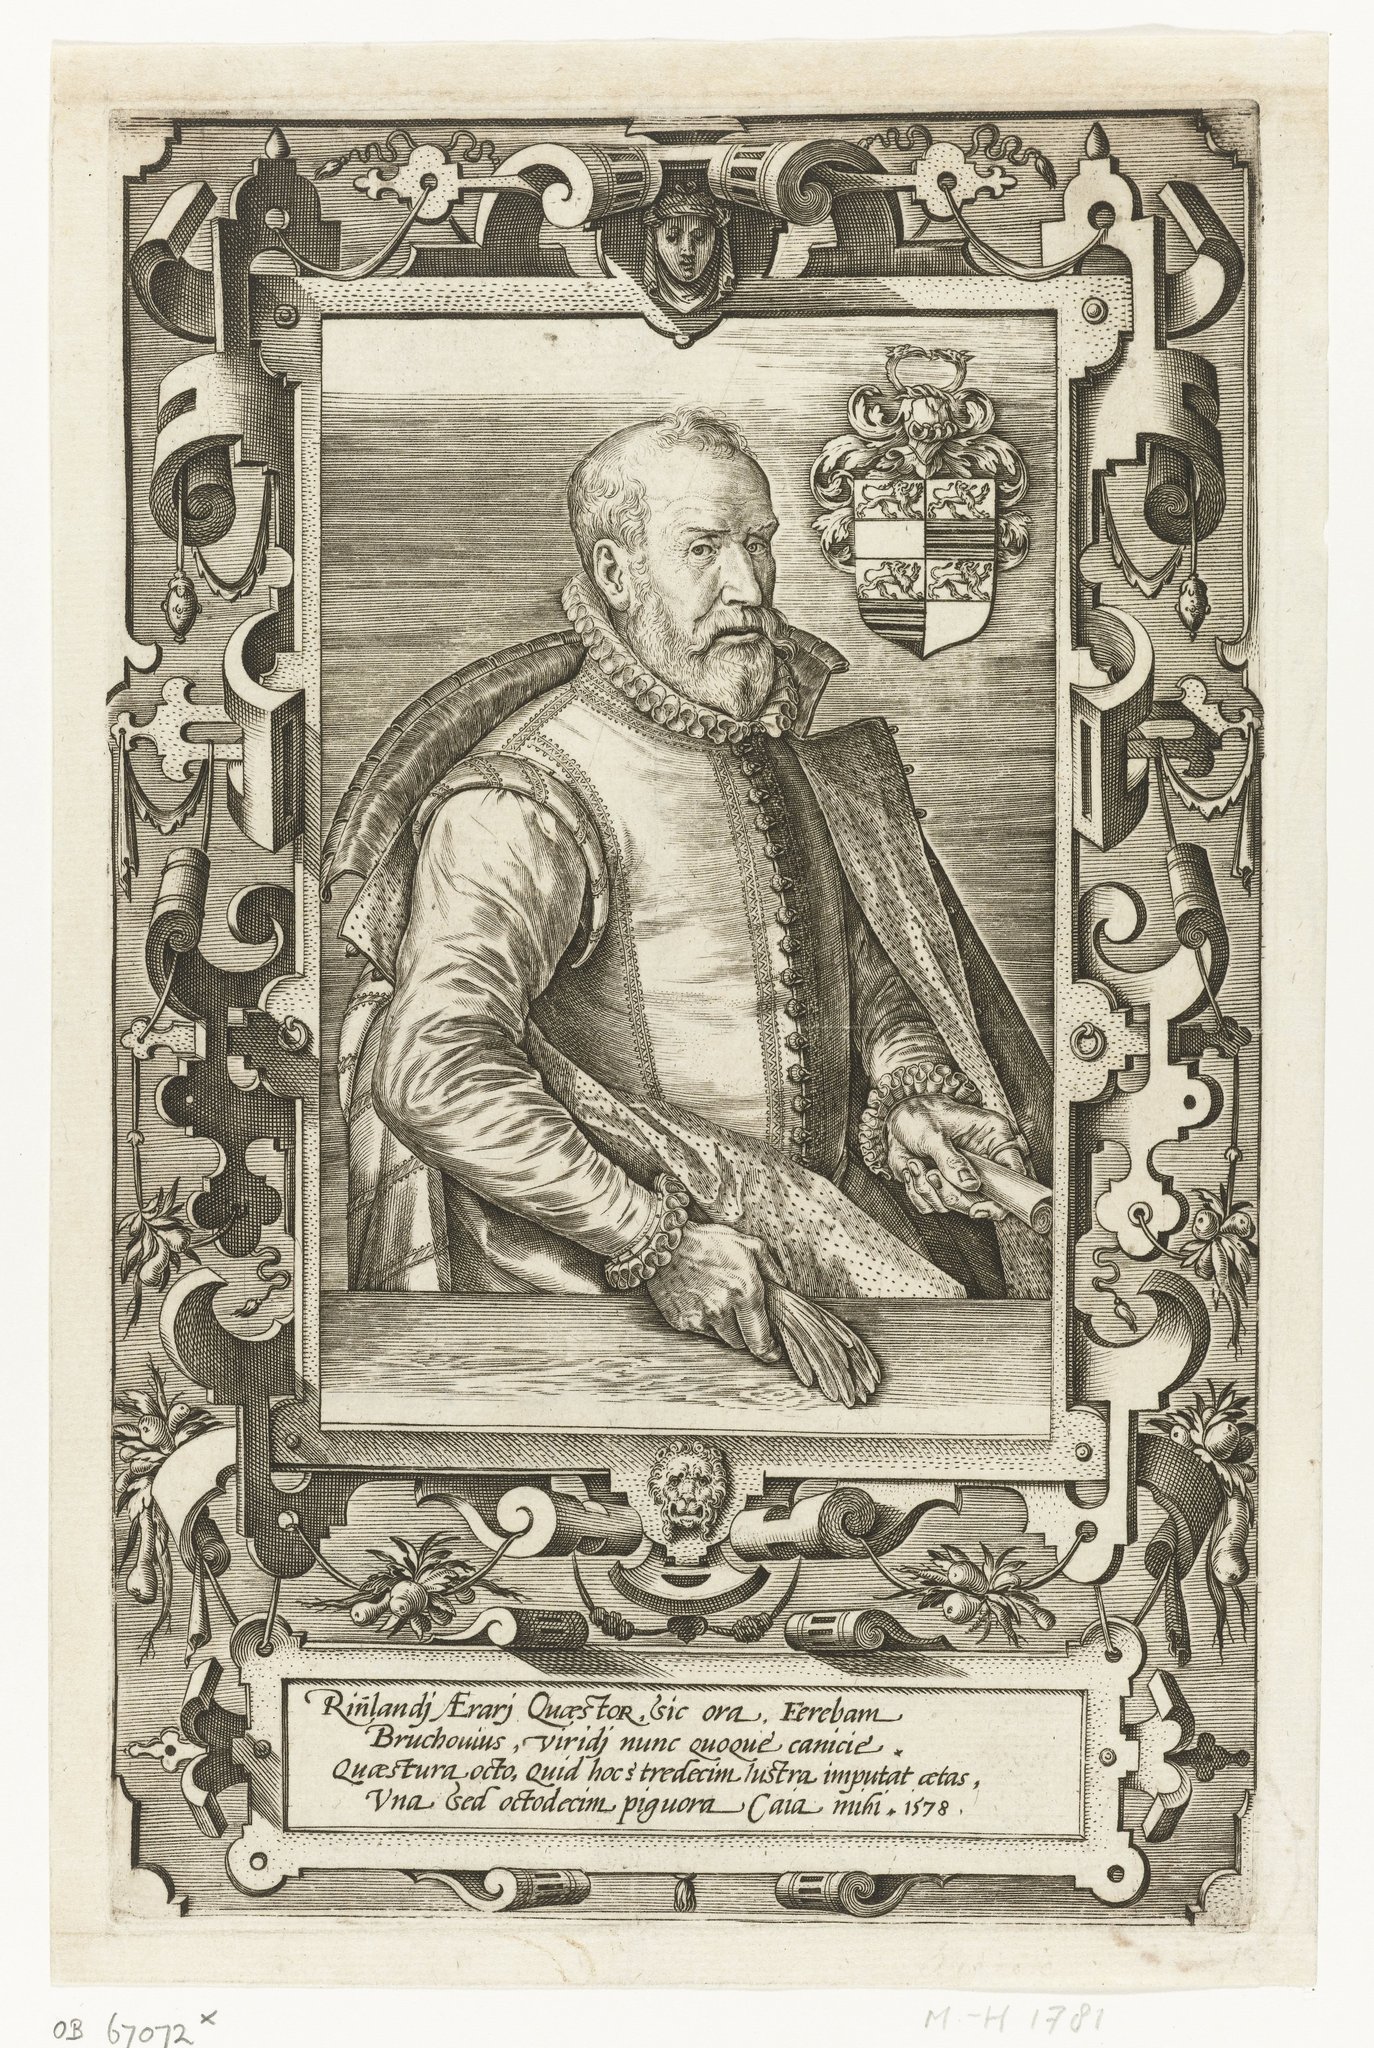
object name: print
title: Portret van Jan van Brouckhoven, rentmeester van Rijnland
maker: johannes wierix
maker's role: draughtsman, print maker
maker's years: 1549-1618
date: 1578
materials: paper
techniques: engraving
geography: delft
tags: scrollwork, strapwork ~ ornament, gloves, mittens, etc., armorial bearing, heraldry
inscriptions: collector's mark: Lugt 240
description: In zijn handen een paar handschoenen en een rol papier. Rechtsboven zijn wapenschild. De voorstelling is gevat in een ornamentele omlijsting. In de cartouche onderaan een vierregelig onderschrift in het Latijn.